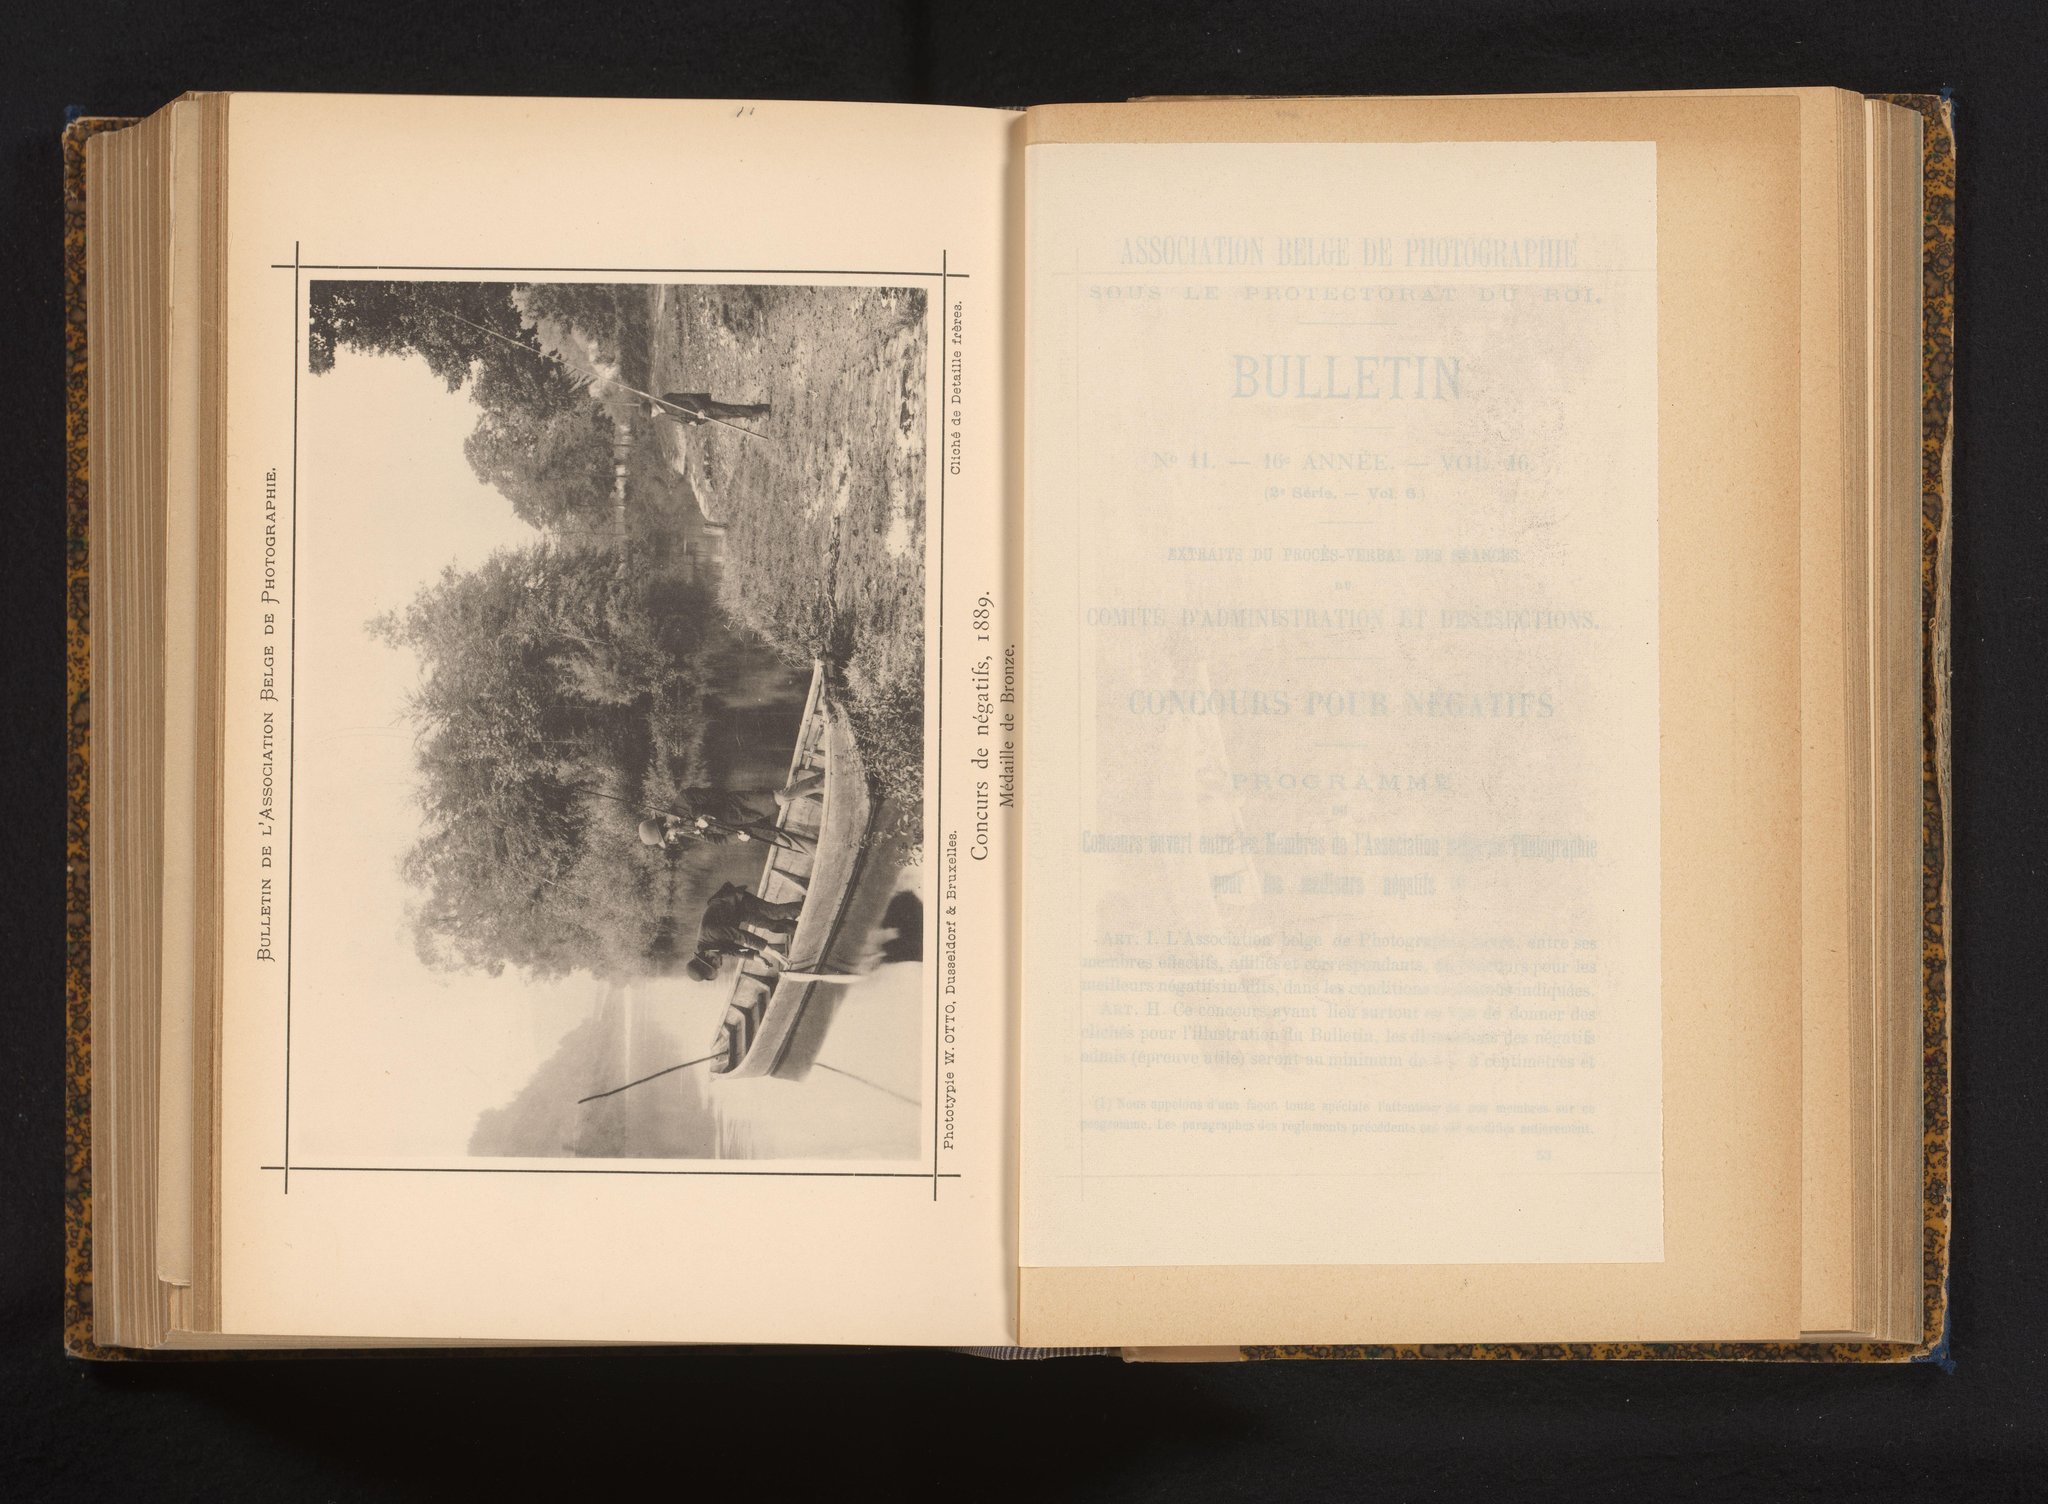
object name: photomechanical print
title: A l'Ile d'Emblève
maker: wilhelm otto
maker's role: printer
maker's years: 1850-1890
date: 1888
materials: paper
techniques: photograph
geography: liège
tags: river, angling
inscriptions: inscription: ‘Concours de négatifs, 1889./ Médaille de Bronze.’